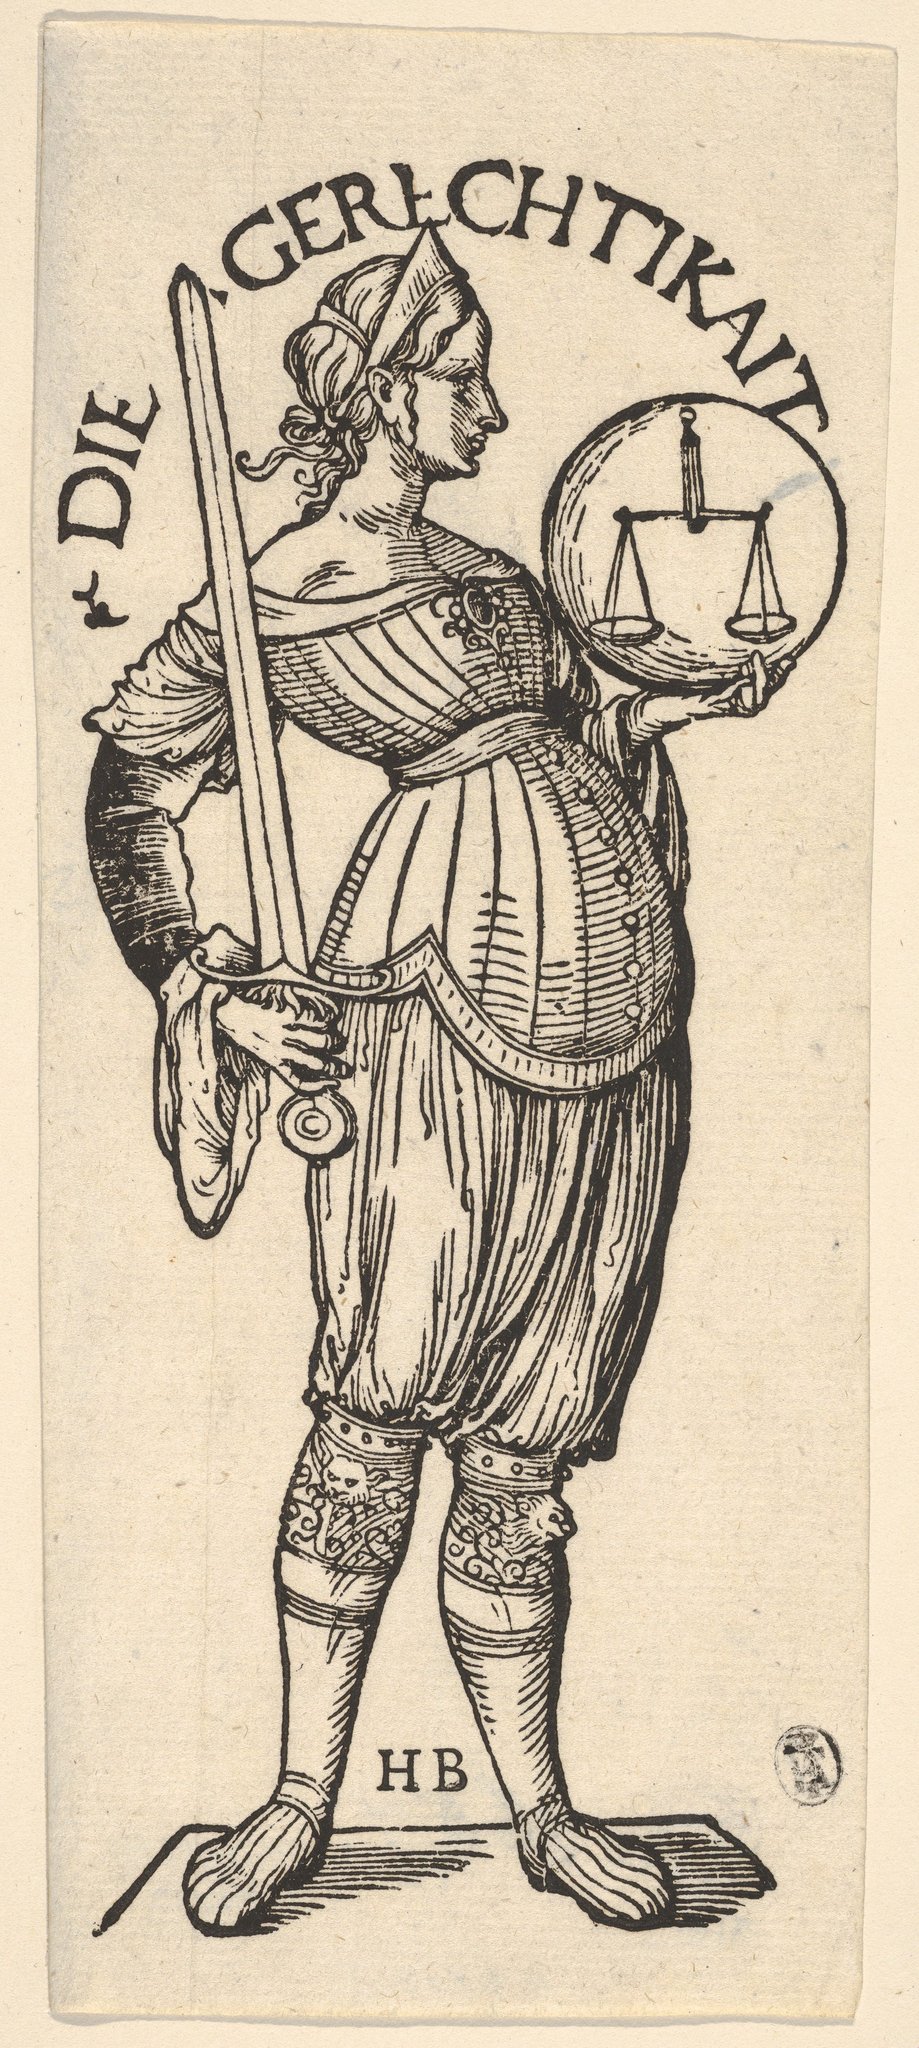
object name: print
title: Justice (Die Gerechtikait), from "The Seven Virtues"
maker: hans burgkmair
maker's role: artist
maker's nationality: german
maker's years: 1473-1531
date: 1498-1531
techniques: woodcut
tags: swords,profiles,women